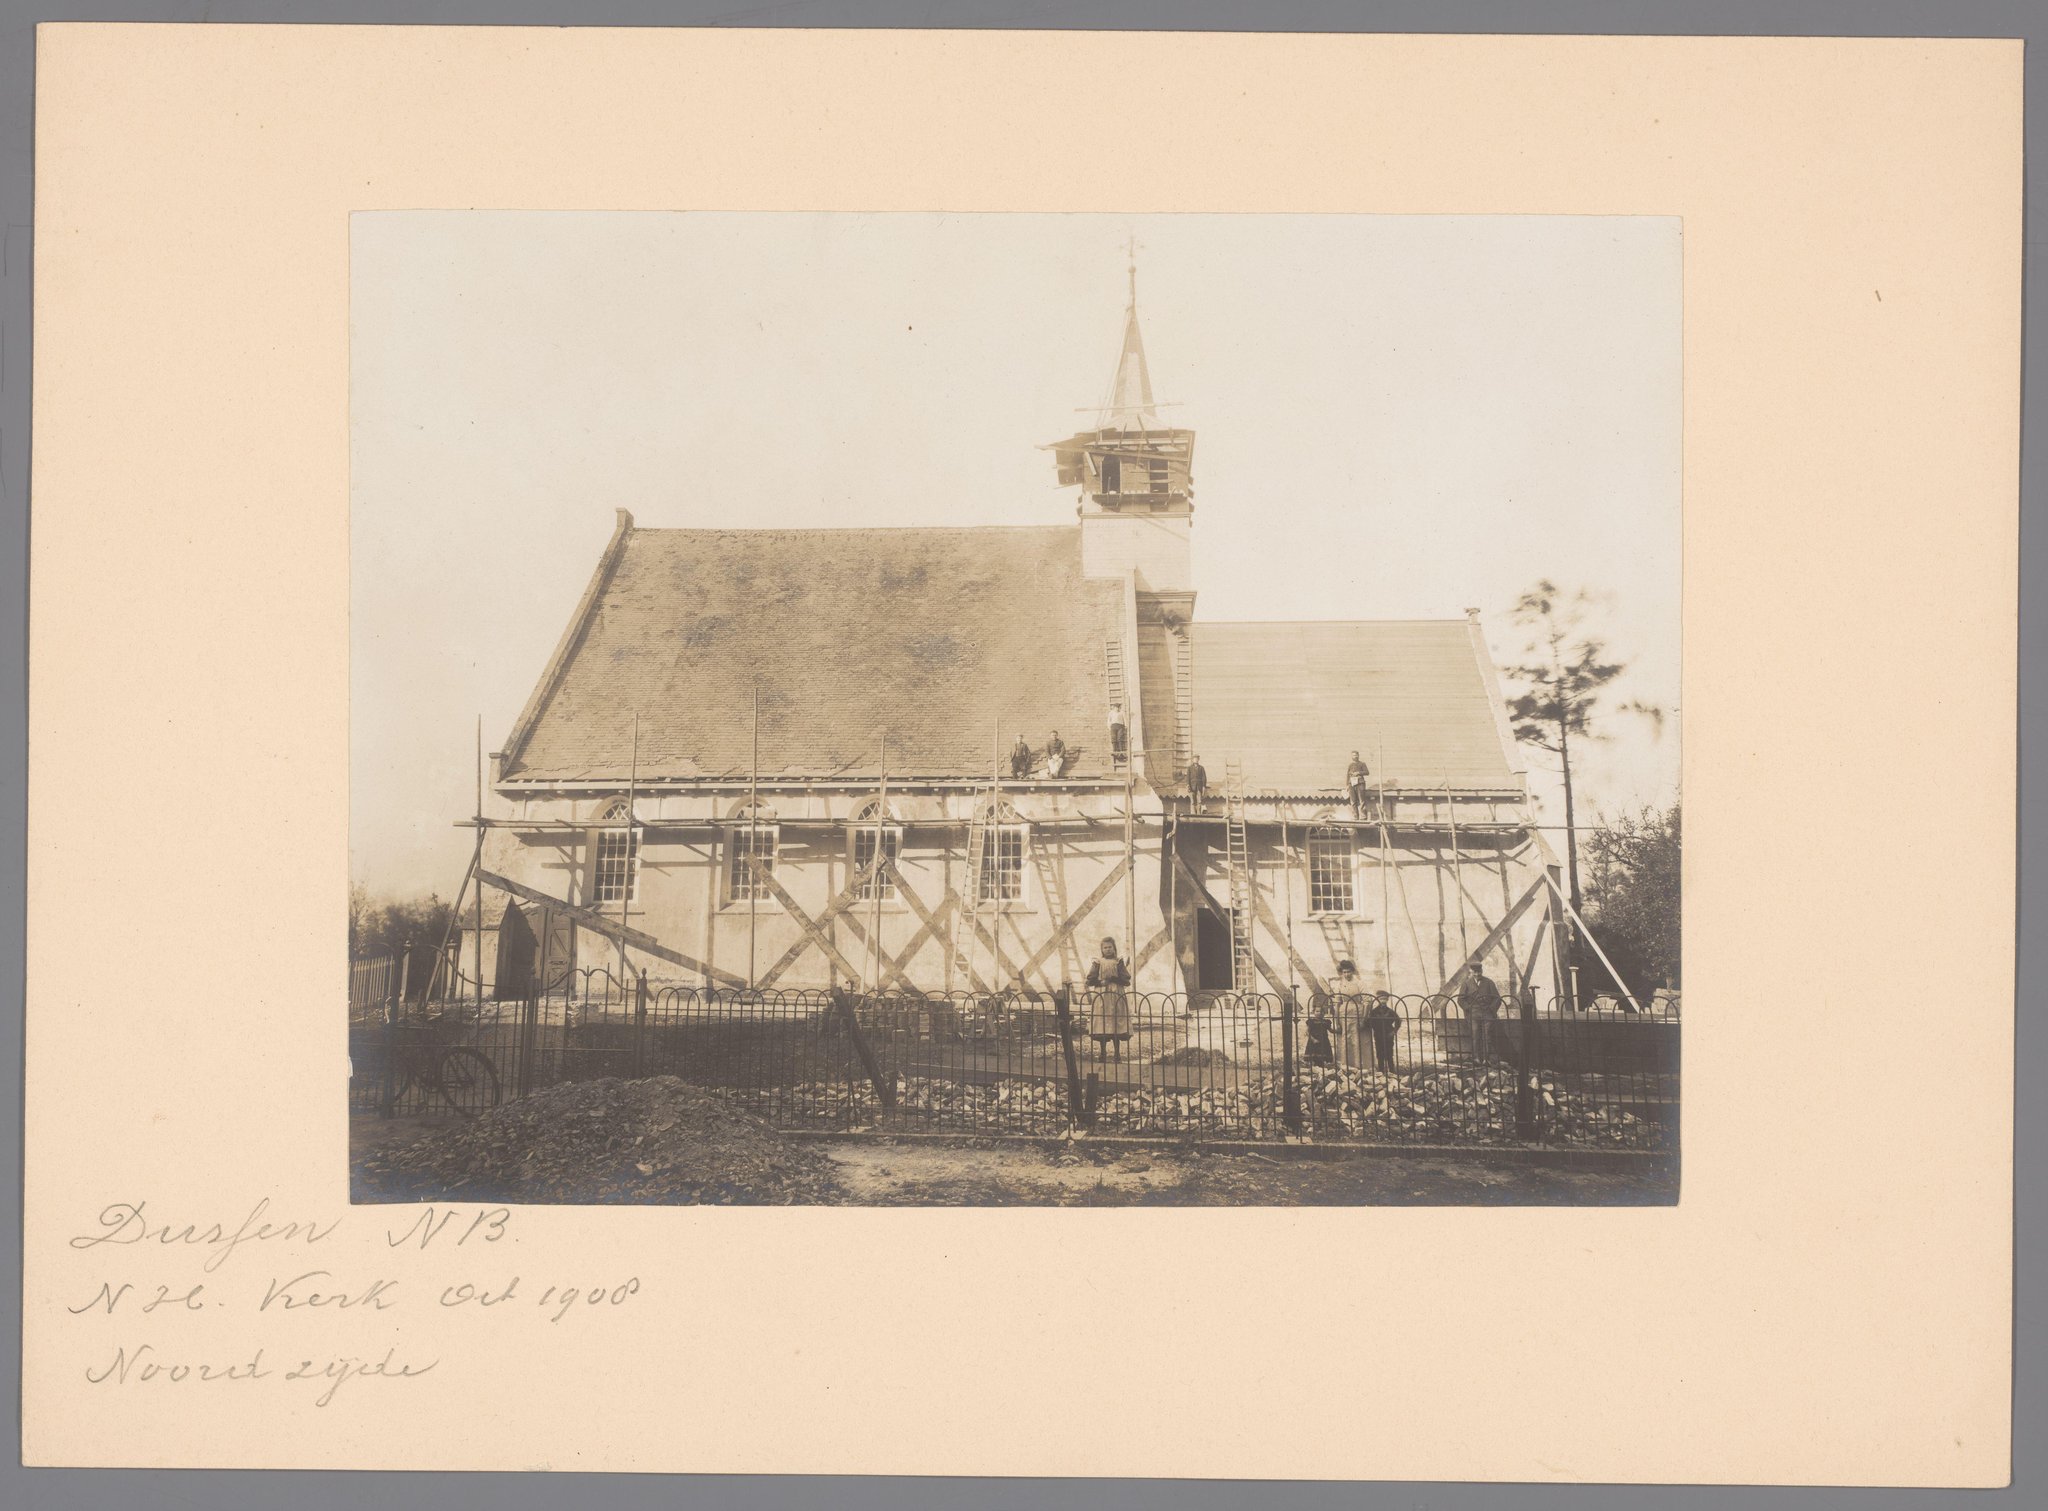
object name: photograph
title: Gezicht op de Hervormde Kerk te Dussen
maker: anoniem (monumentenzorg)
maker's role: fotograaf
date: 1908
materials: cardboard, photographic support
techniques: gelatin silver print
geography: dussen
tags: church (exterior)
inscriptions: annotation: ‘Dussen NB./ N.H. Kerk/ oct. 1908’